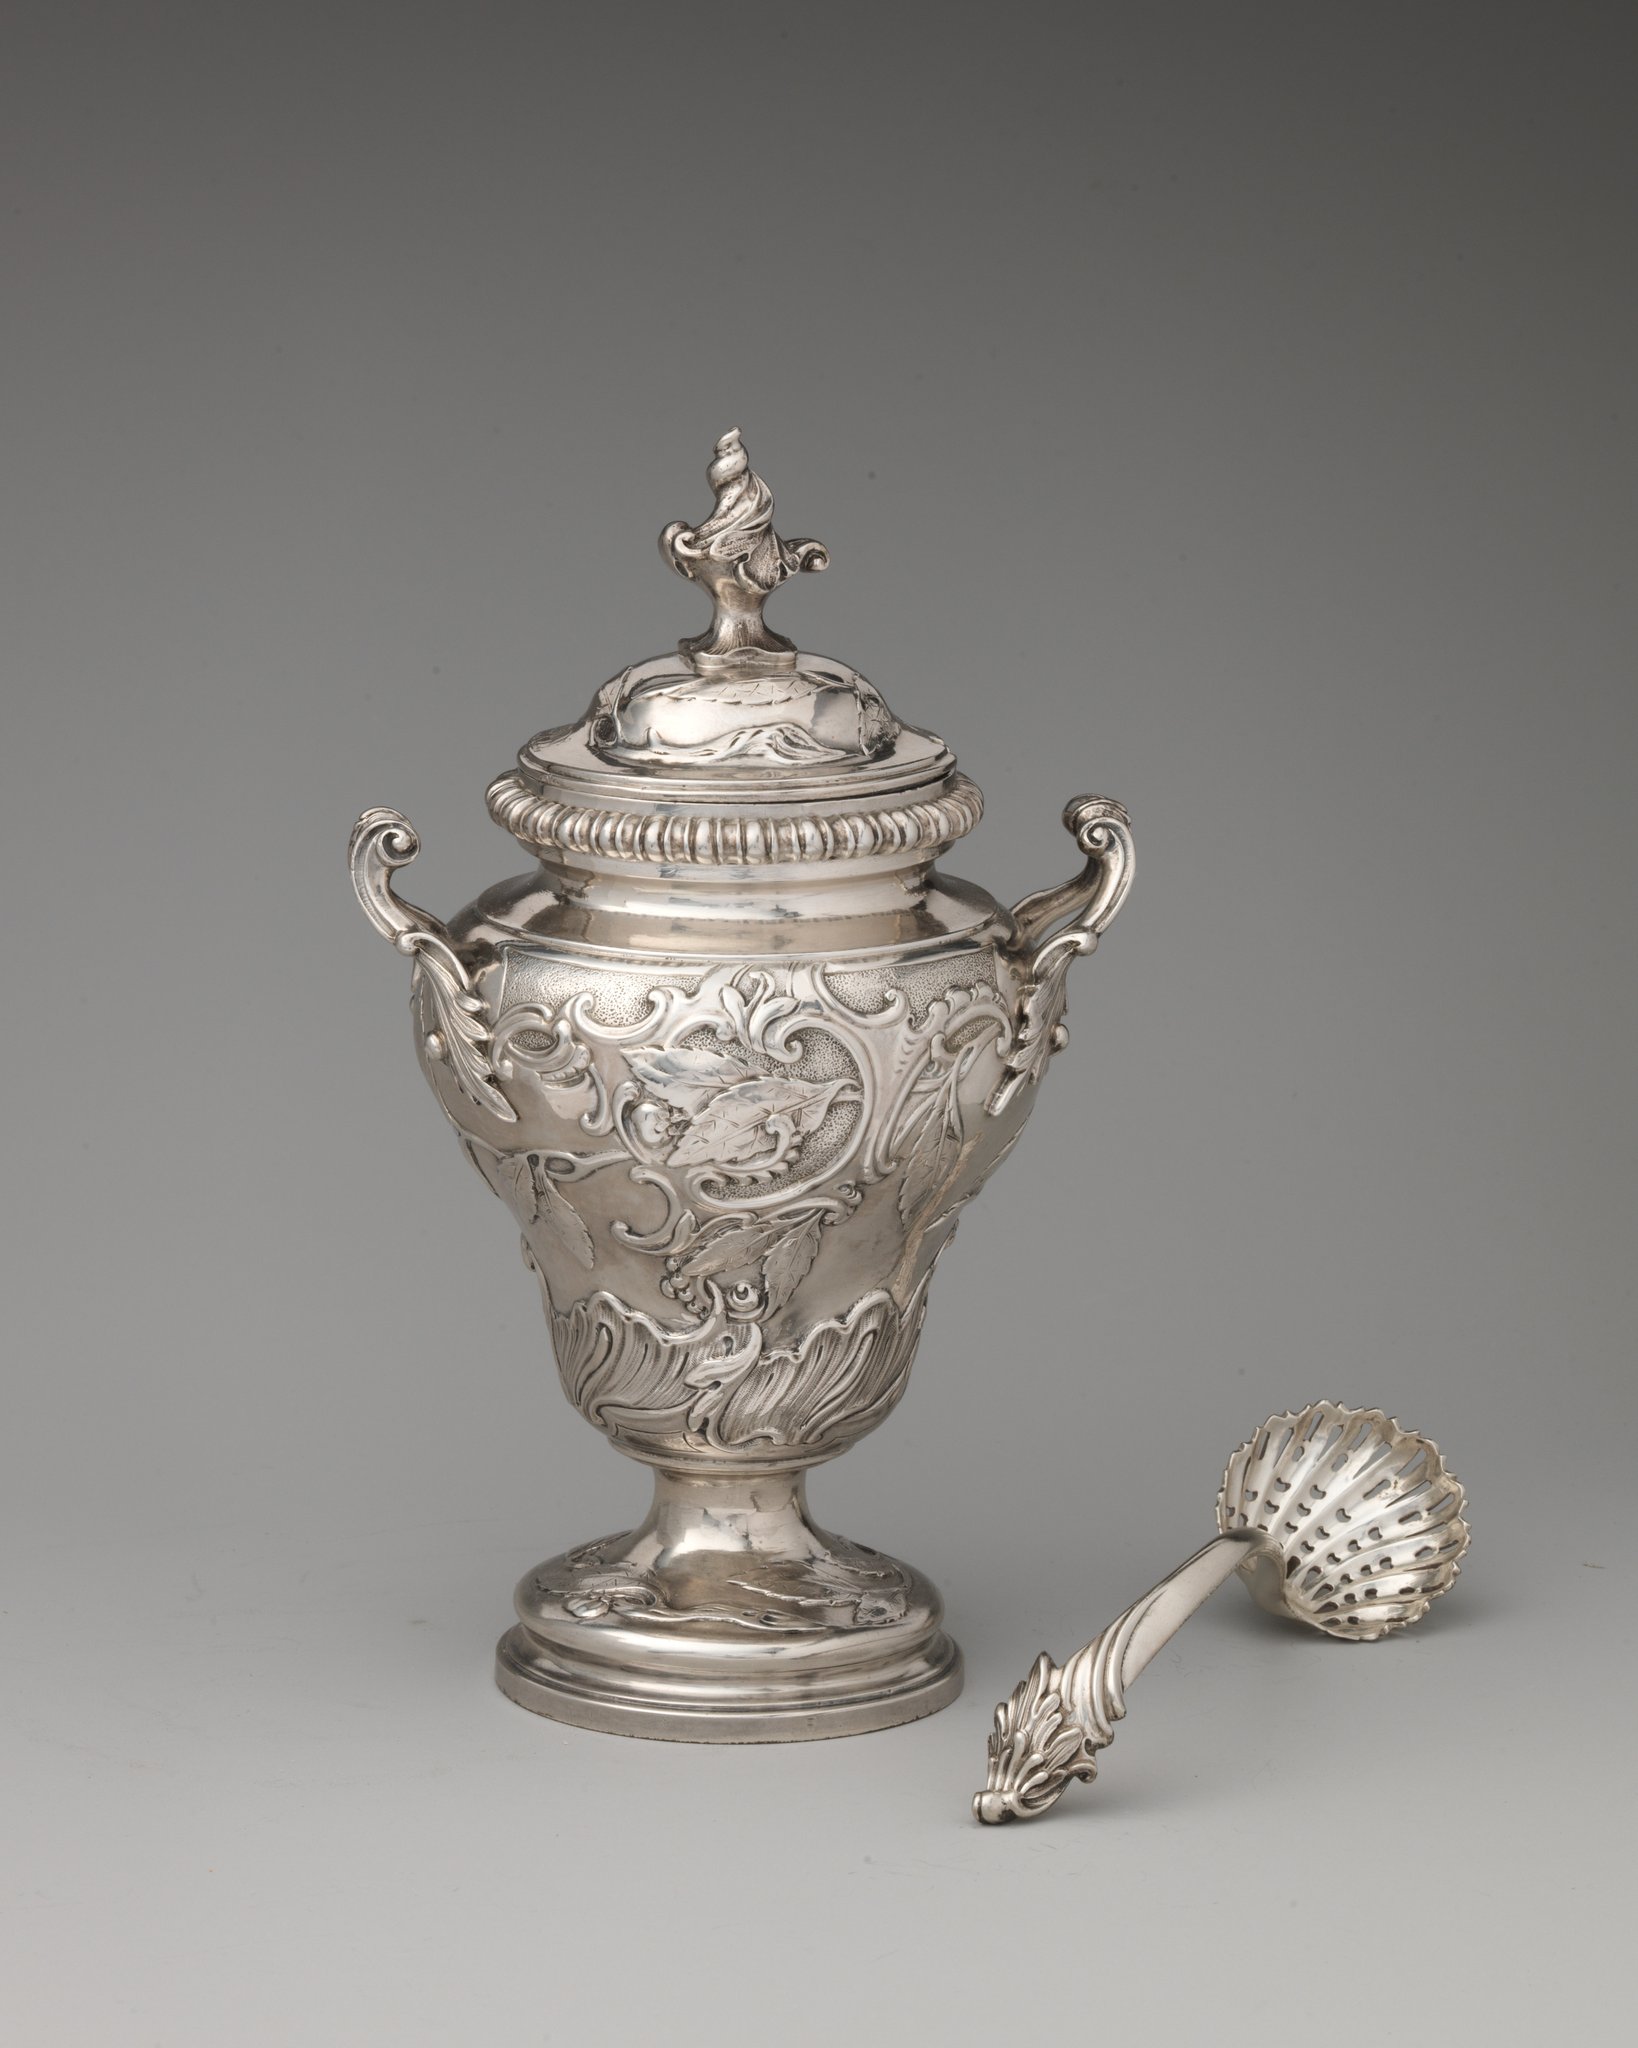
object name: tea caddy with spoon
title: Tea caddy with spoon (one of a set of three)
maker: john swift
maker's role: maker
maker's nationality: british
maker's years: 1728-1828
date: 1762-1763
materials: silver